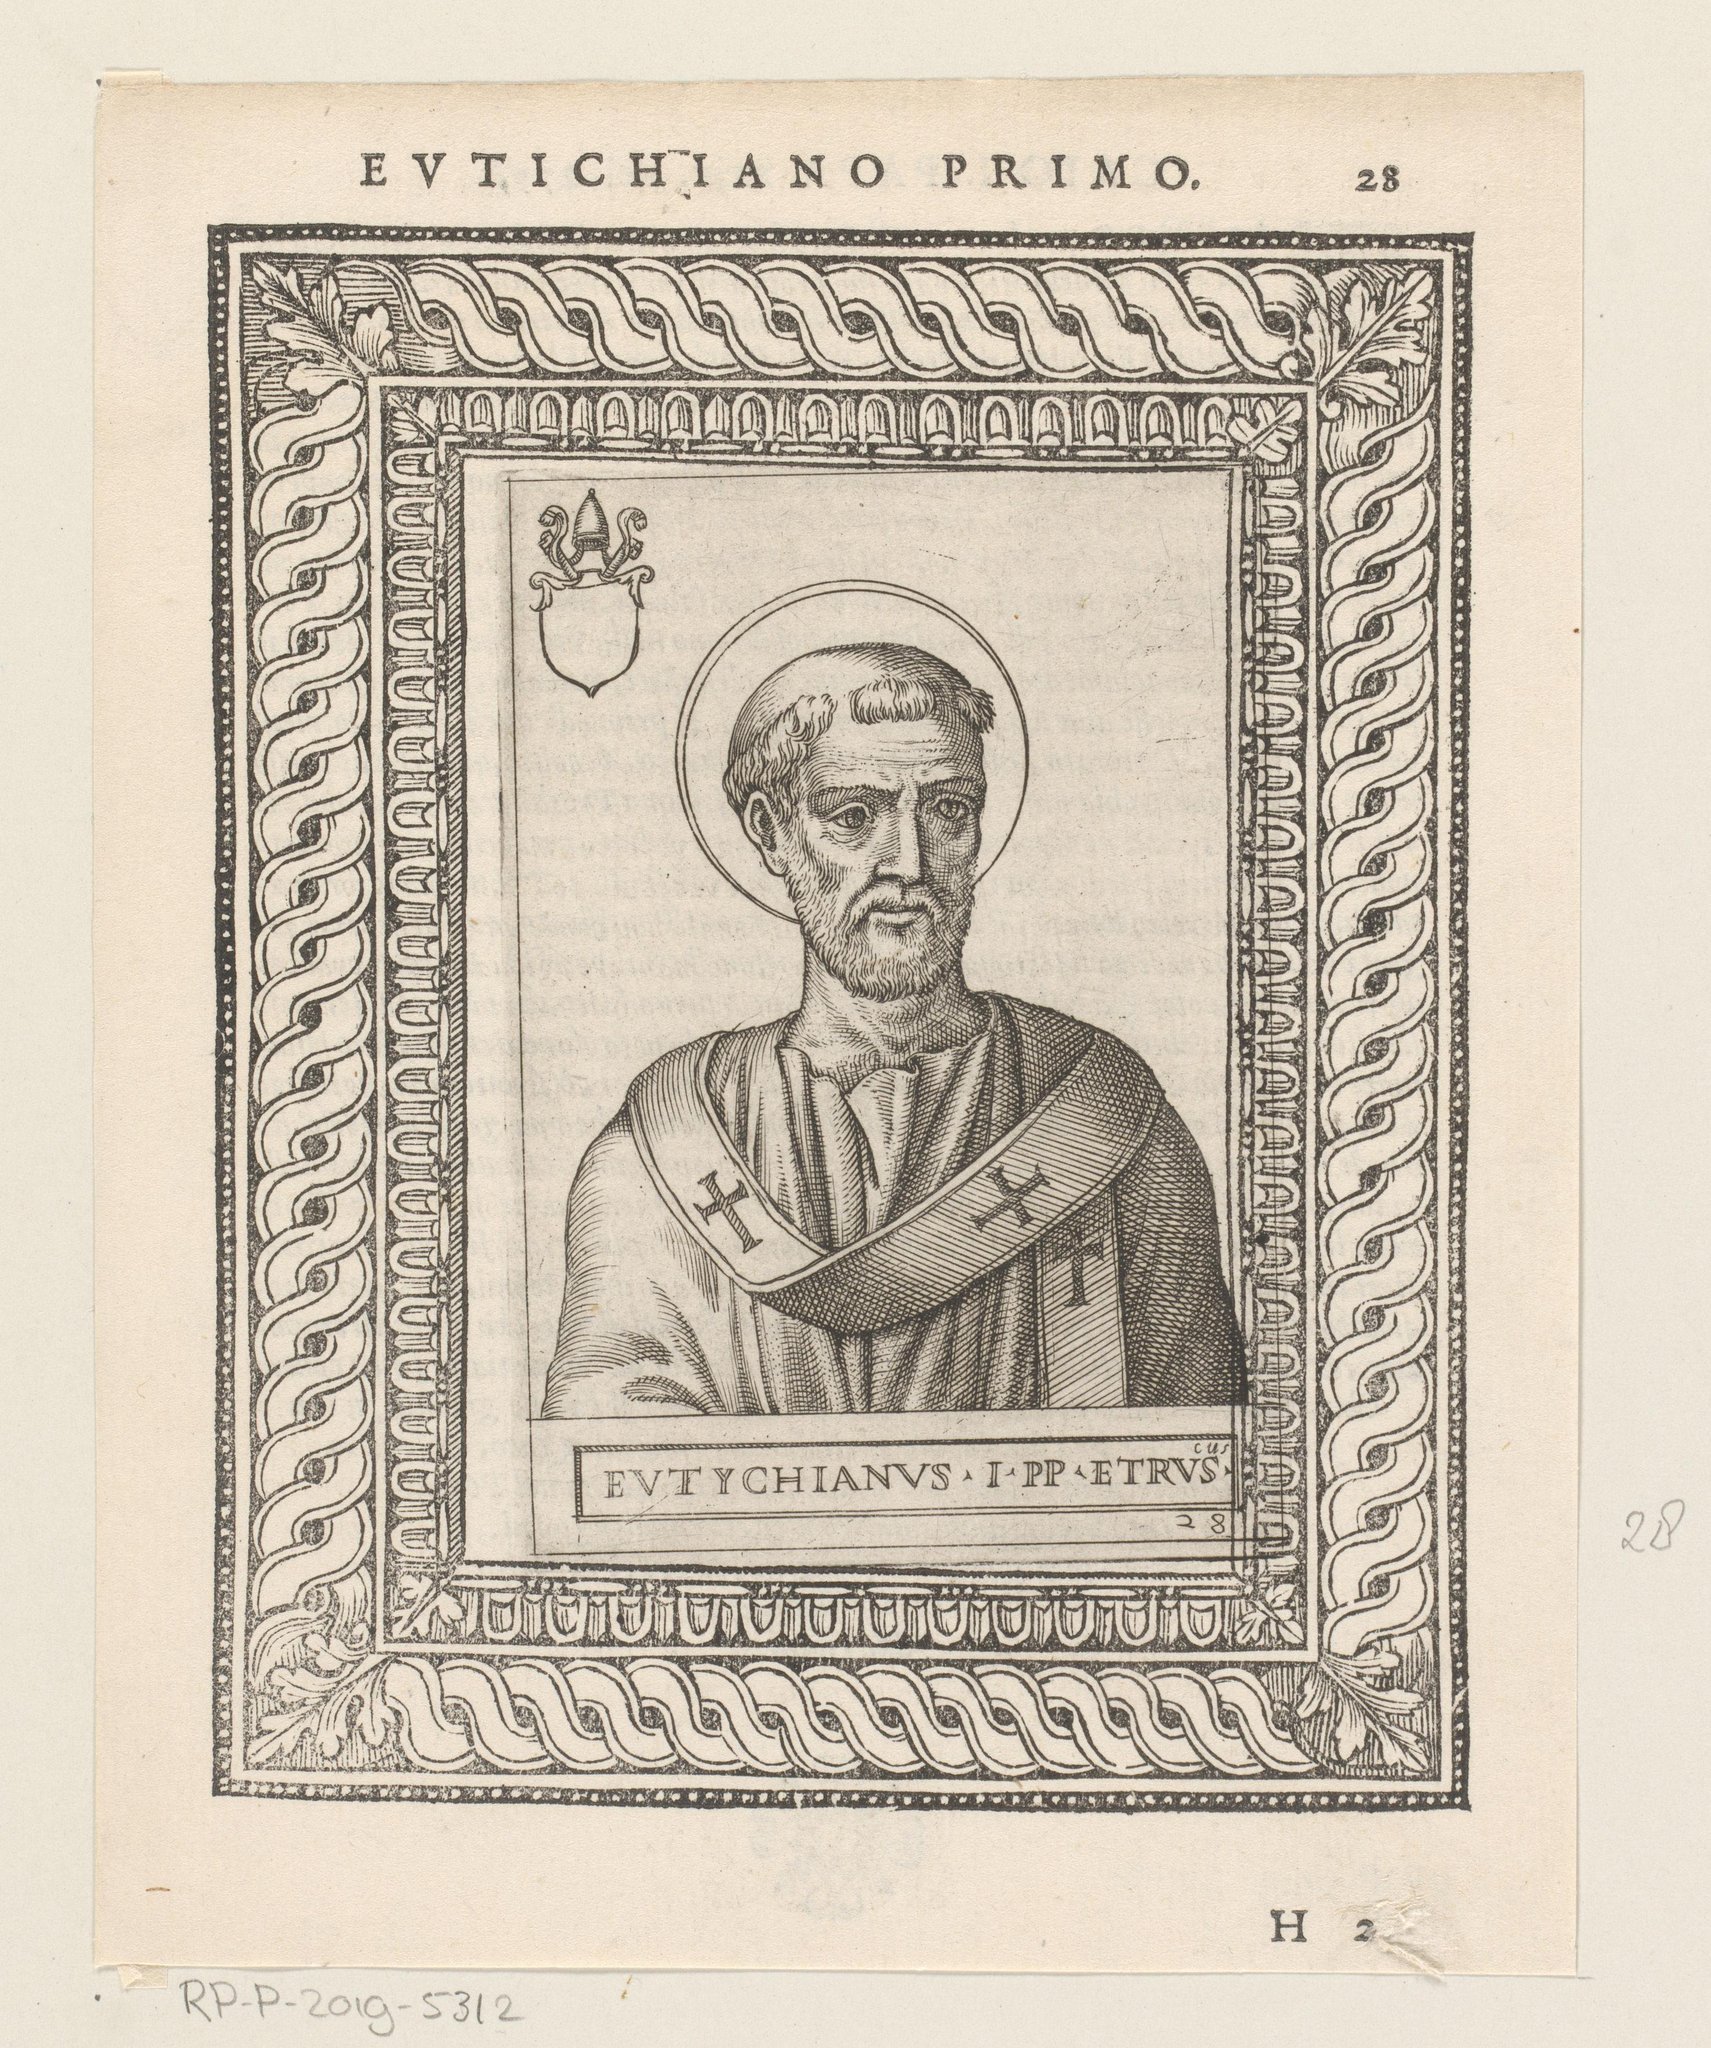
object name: book illustration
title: Eutychianus I PP Etruscus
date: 1587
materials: paper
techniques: engraving, letterpress printing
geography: rome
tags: historical persons, pope, armorial bearing, heraldry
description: Prent uit: Ciccarelli, Antonio. Le vite de Pontefici di Antonio Ciccarelli (...). Rome: Domenico Basa, 1587. Prent voor het eerst verschenen in: Cavalieri, Giovanni Battista de'. Pontificum romanorum effigies (...). Rome: Domenico Basa en Francesco Zanetti, 1580. Prent ook gebruikt in latere publicaties.